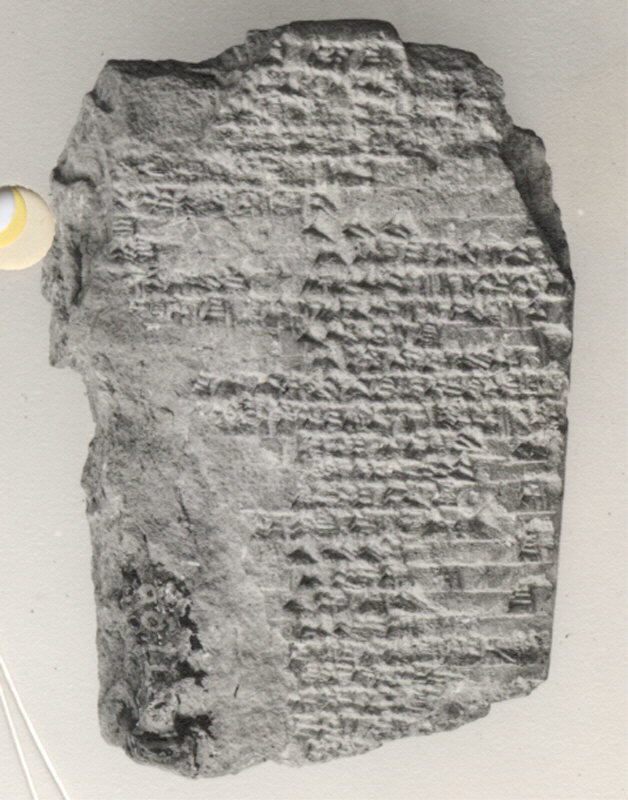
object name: cuneiform tablet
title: Cuneiform tablet: dilmun nigin-na, ershemma, to Marduk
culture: parthian or seleucid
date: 200-1 BCE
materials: clay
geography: mesopotamia